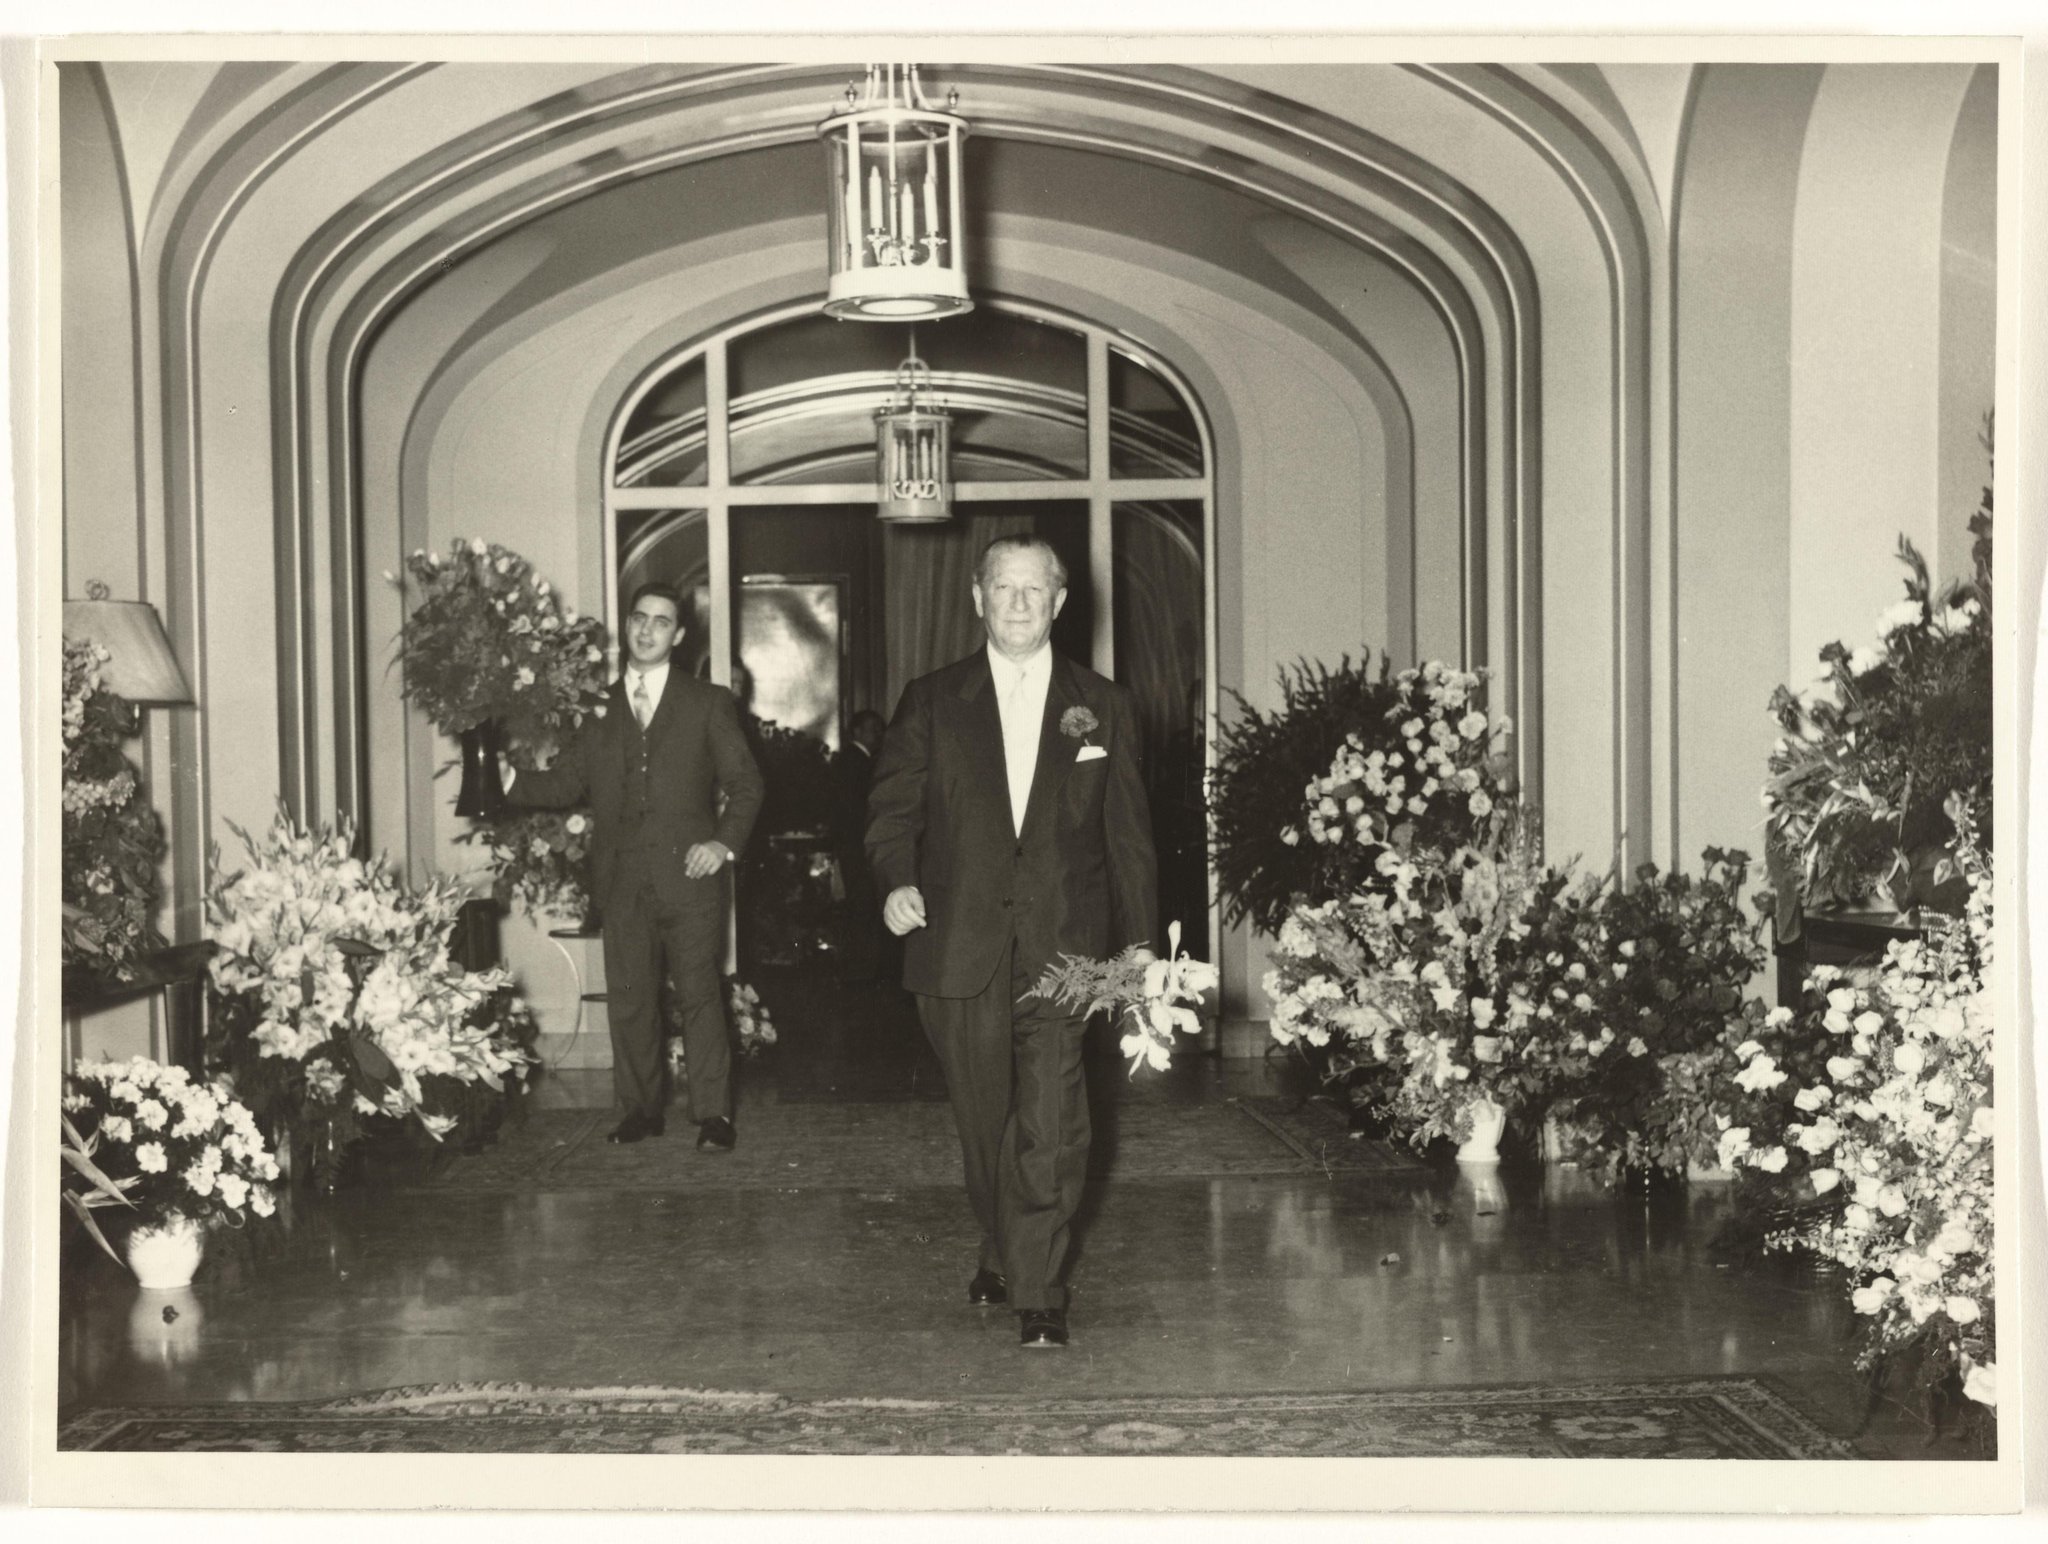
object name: photograph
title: Willy Moos lopend door een hal met bloemen aan weerszijden, met lampen aan het plafond en een man met bloemstuk in zijn hand op de achtergrond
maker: Anonymous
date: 1930-1955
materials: photographic support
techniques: gelatin silver print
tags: willy moos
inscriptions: address: ‘Foto arte Valdez Tucuman 415 T.E. 31-3674 Bs.As.’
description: Willy Moos lopend door een hal met bloemen aan weerszijden, met lampen aan het plafond en een man met bloemstuk in zijn hand op de achtergrond.